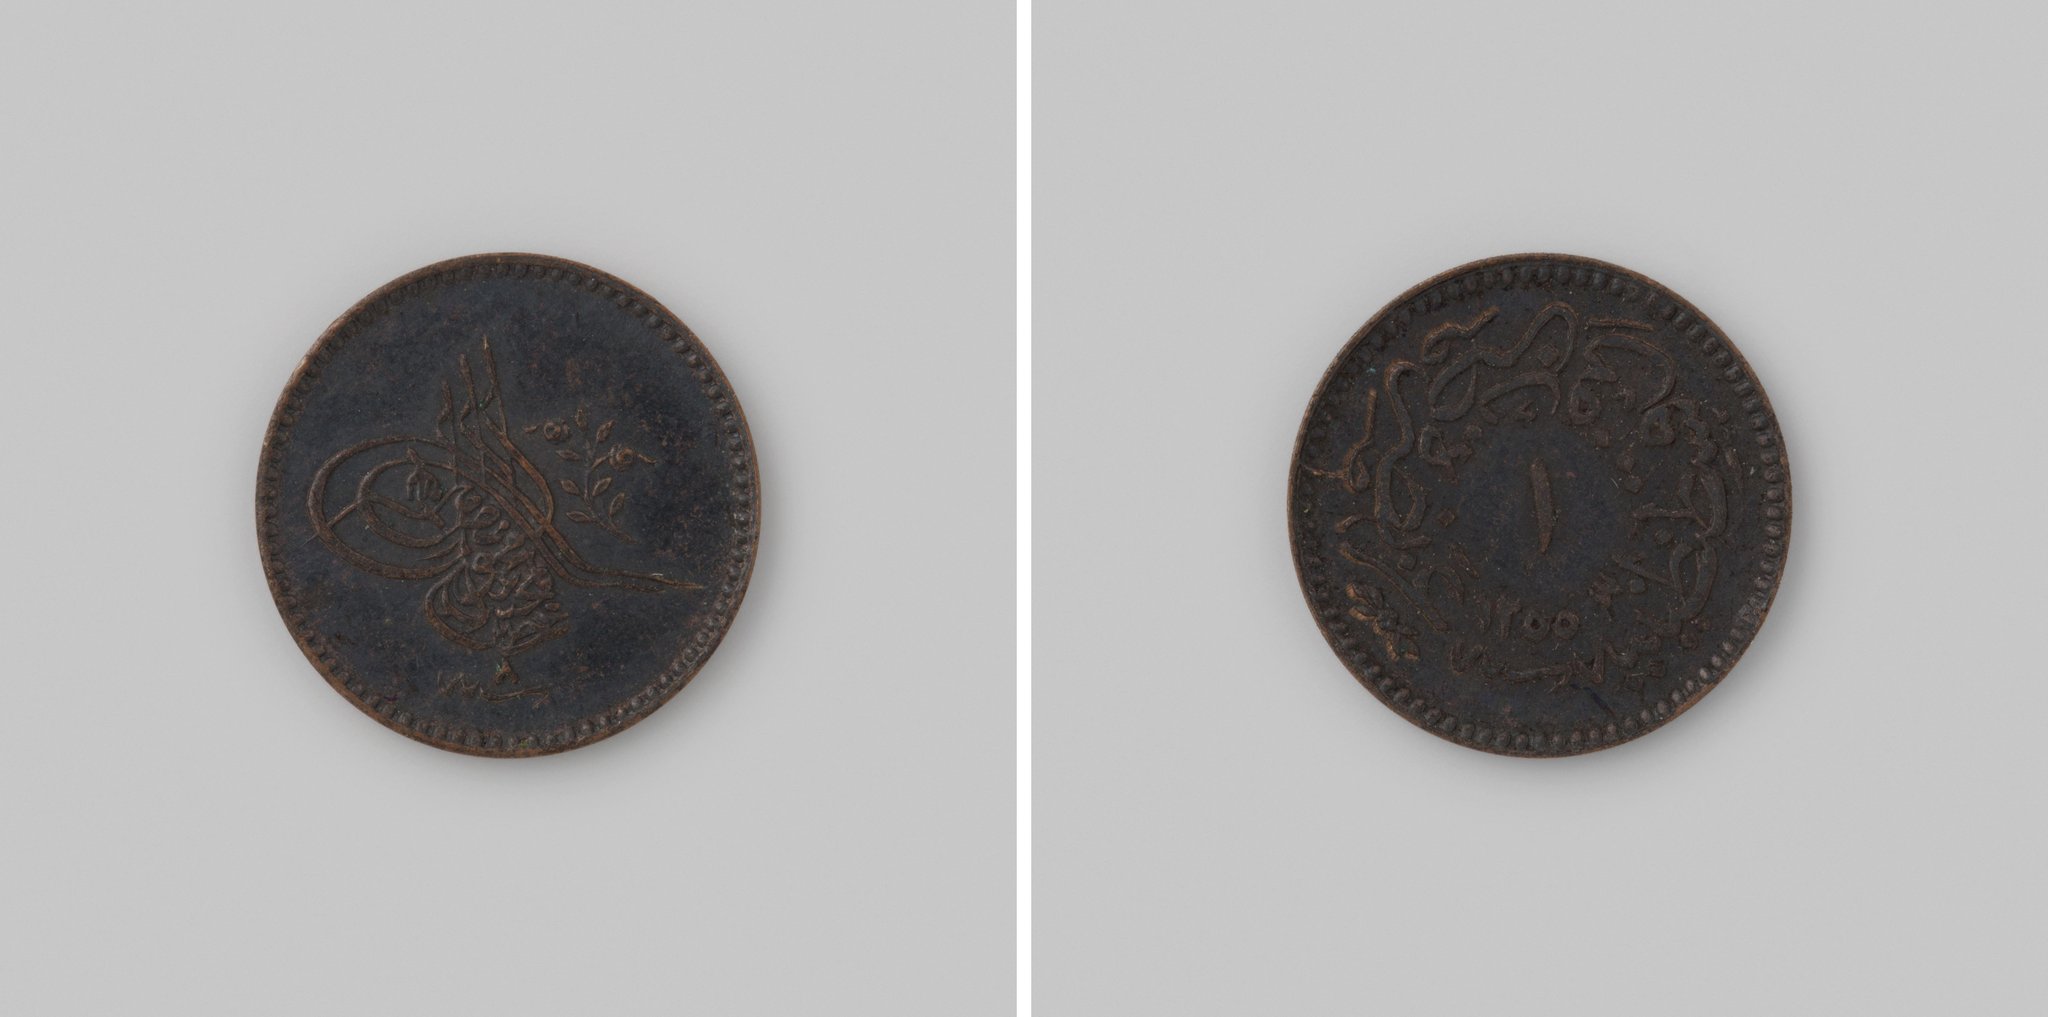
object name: coin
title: Para uit Turkije van sultan Abdul Medjid, regeringsjaar 8 [=1846]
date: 1846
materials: copper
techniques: striking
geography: constantinople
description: Koperen munt. Voorzijde: tughra met rechts daarvan takje met bladeren. Onder tughra regeringsjaar-aanduiding: 8. Keerzijde: binnen omschrift in Arabische letters waarde-aanduiding: 1. In omschrift muntplaats-aanduiding: Constantinopel en aanduiding jaar van aantreden: 1255 [=1839].